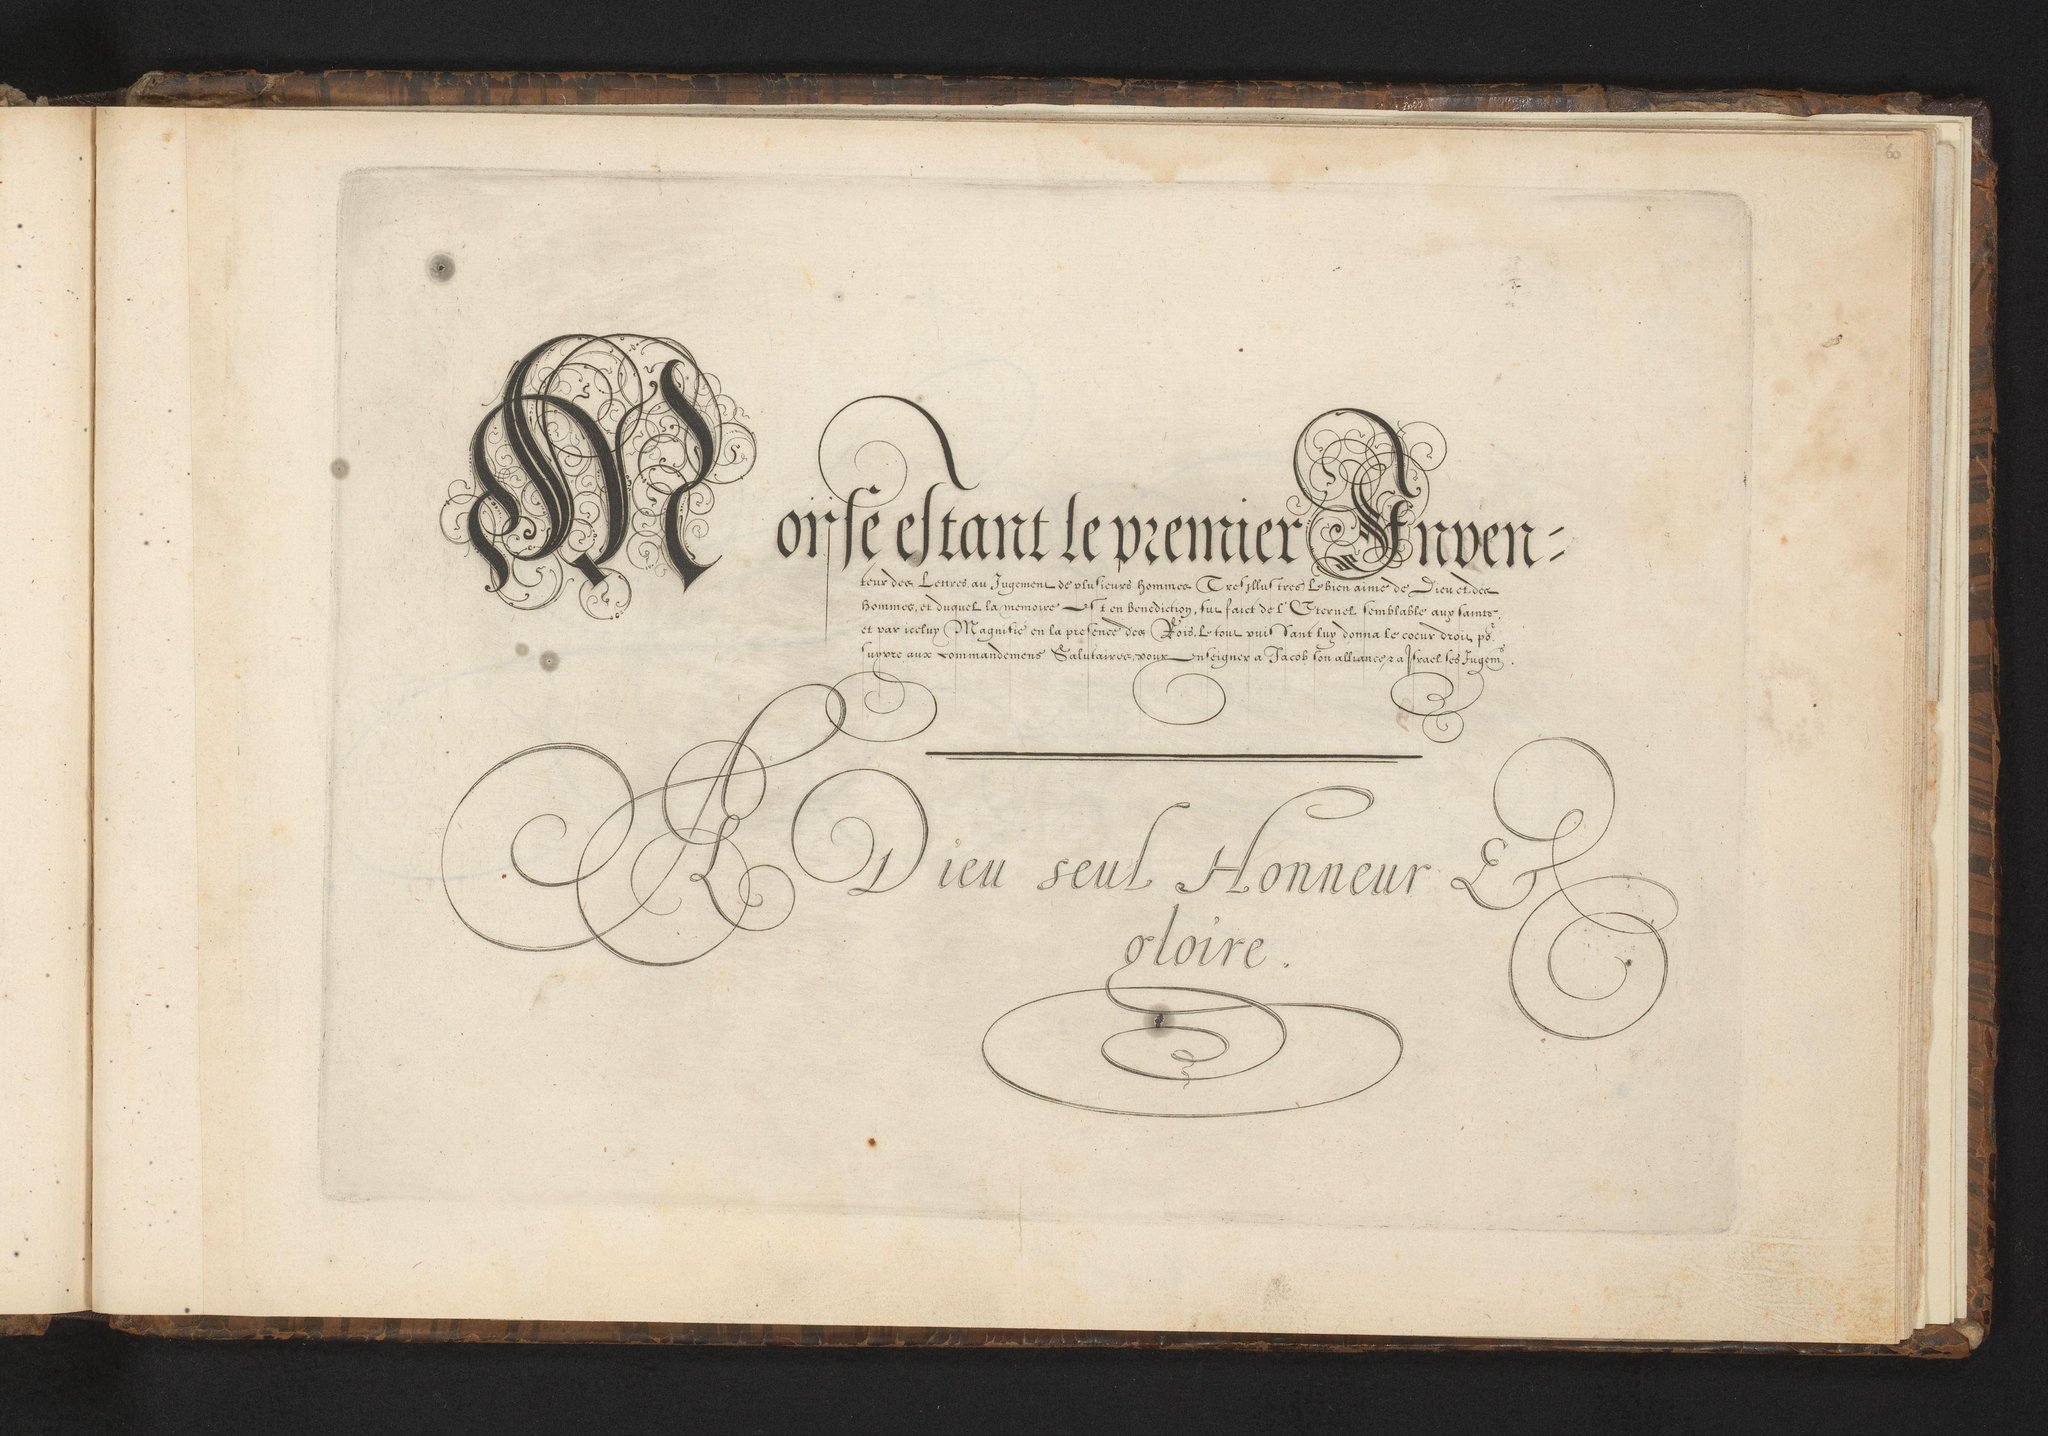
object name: album leaf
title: Schrijfvoorbeeld: Moijse estant le premier inventeur (...)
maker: cornelis dircksz. boissens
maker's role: draughtsman, print maker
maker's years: 1567-1635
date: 1605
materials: paper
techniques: engraving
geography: amsterdam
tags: calligraphy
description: Schrijfvoorbeeld met vijf regels tekst in het Frans: Moijse estant le premier inventeur ... Daaronder de tekst: A Dieu seul Honneur et gloire. De prent maakt deel uit van een album.